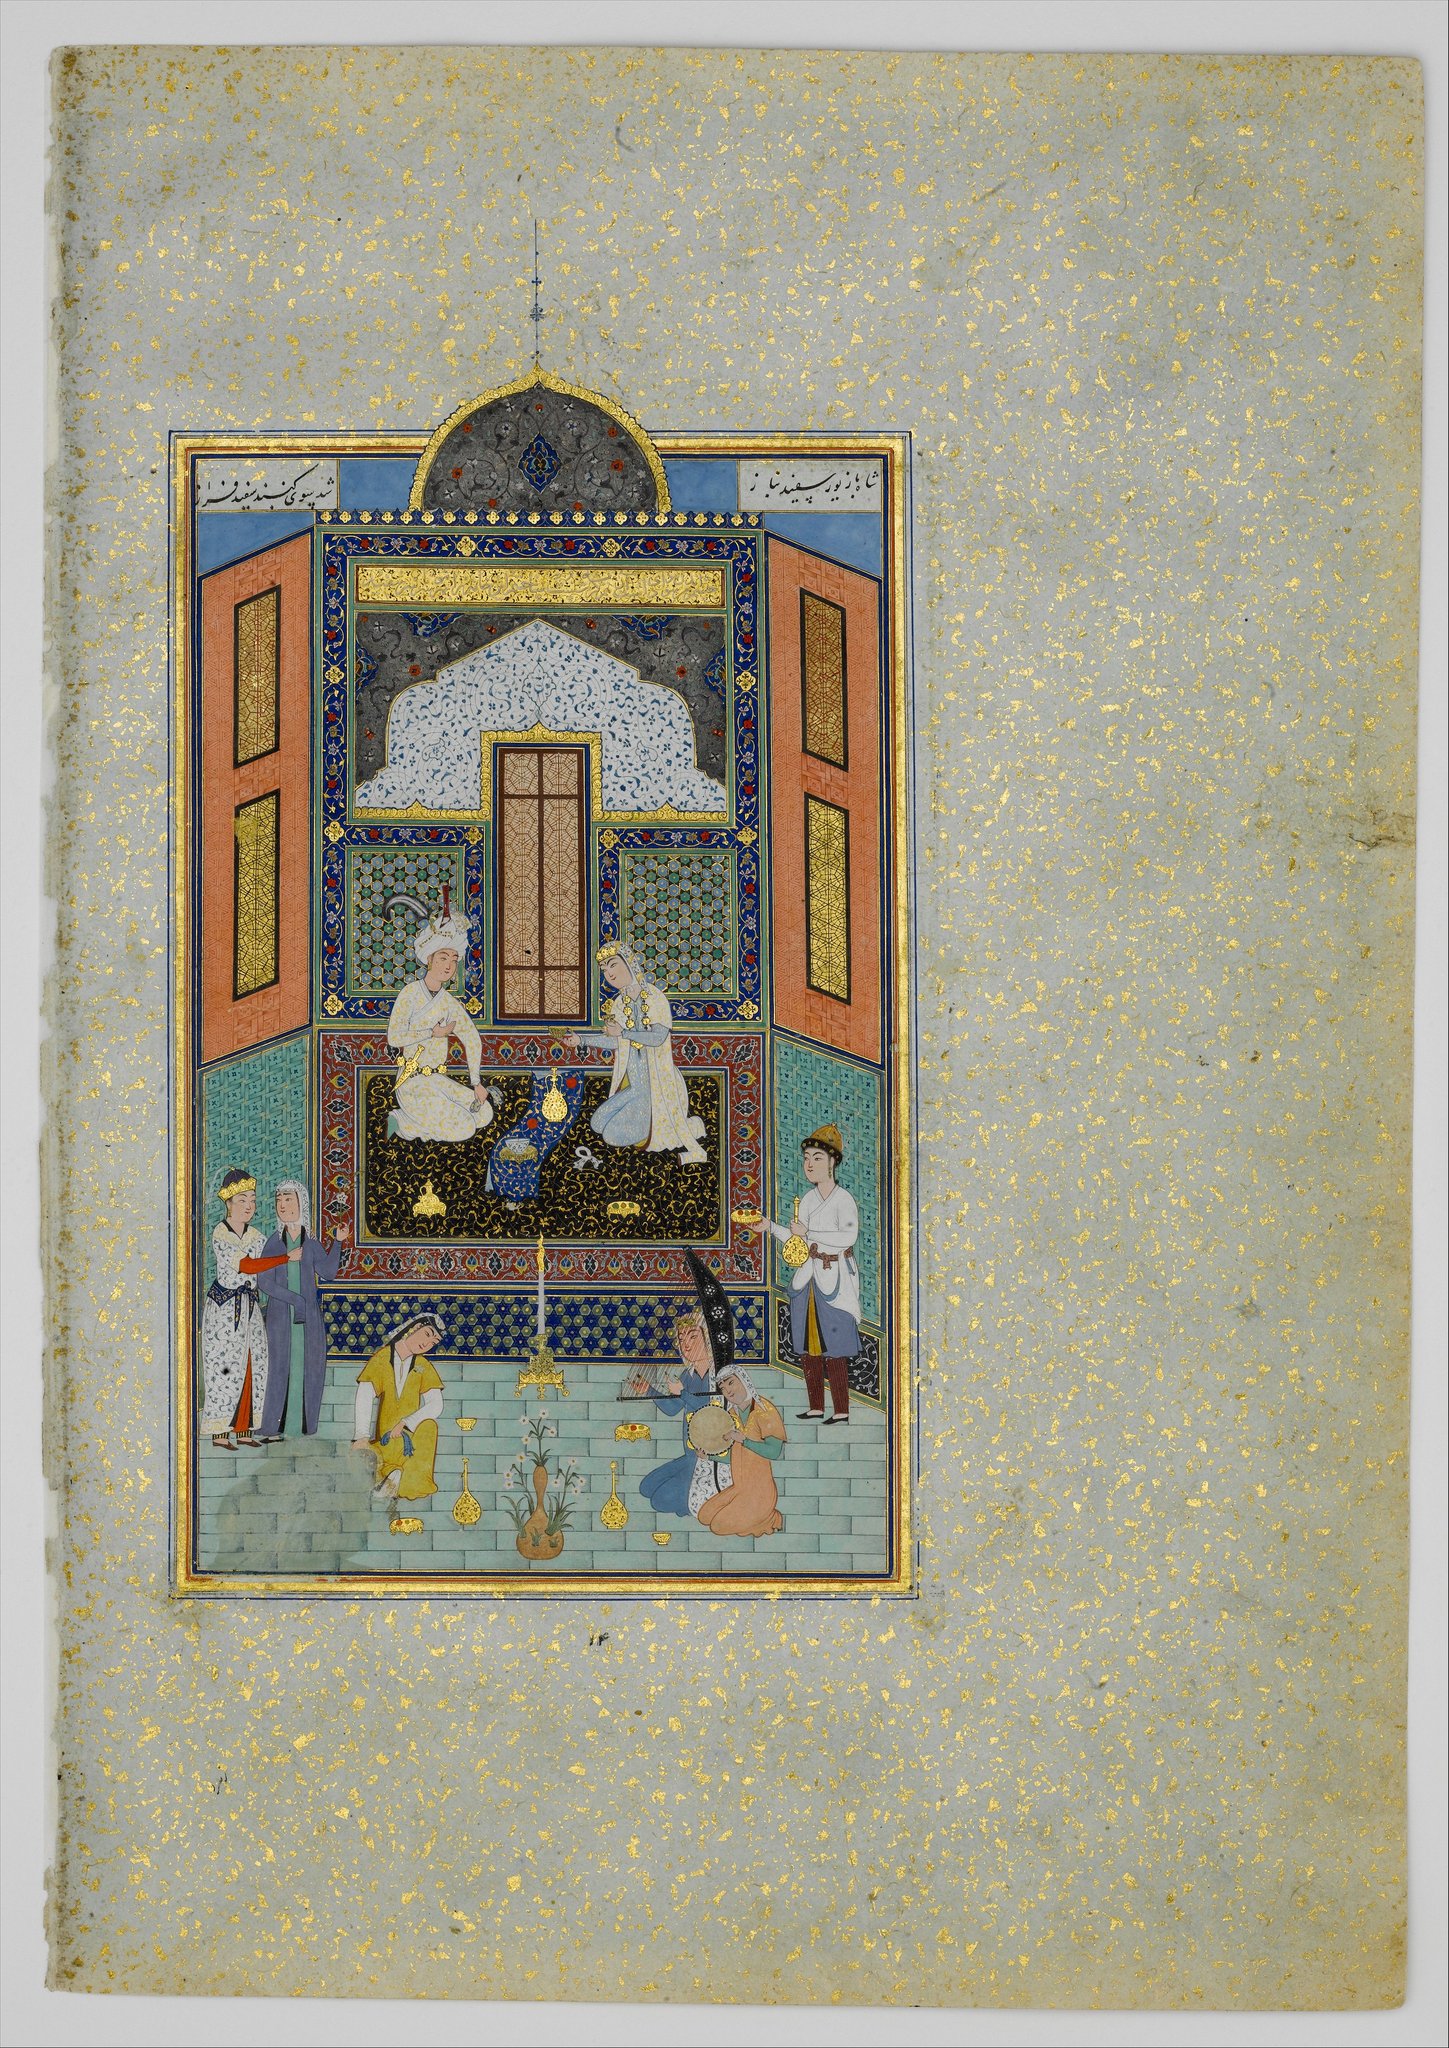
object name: folio from an illustrated manuscript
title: "Bahram Gur in the White Palace on Friday", Folio 235 from a Khamsa (Quintet) of Nizami of Ganja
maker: nizami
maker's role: author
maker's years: 1141-1209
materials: gold, ink, paper, watercolor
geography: afghanistan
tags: interiors,men,women